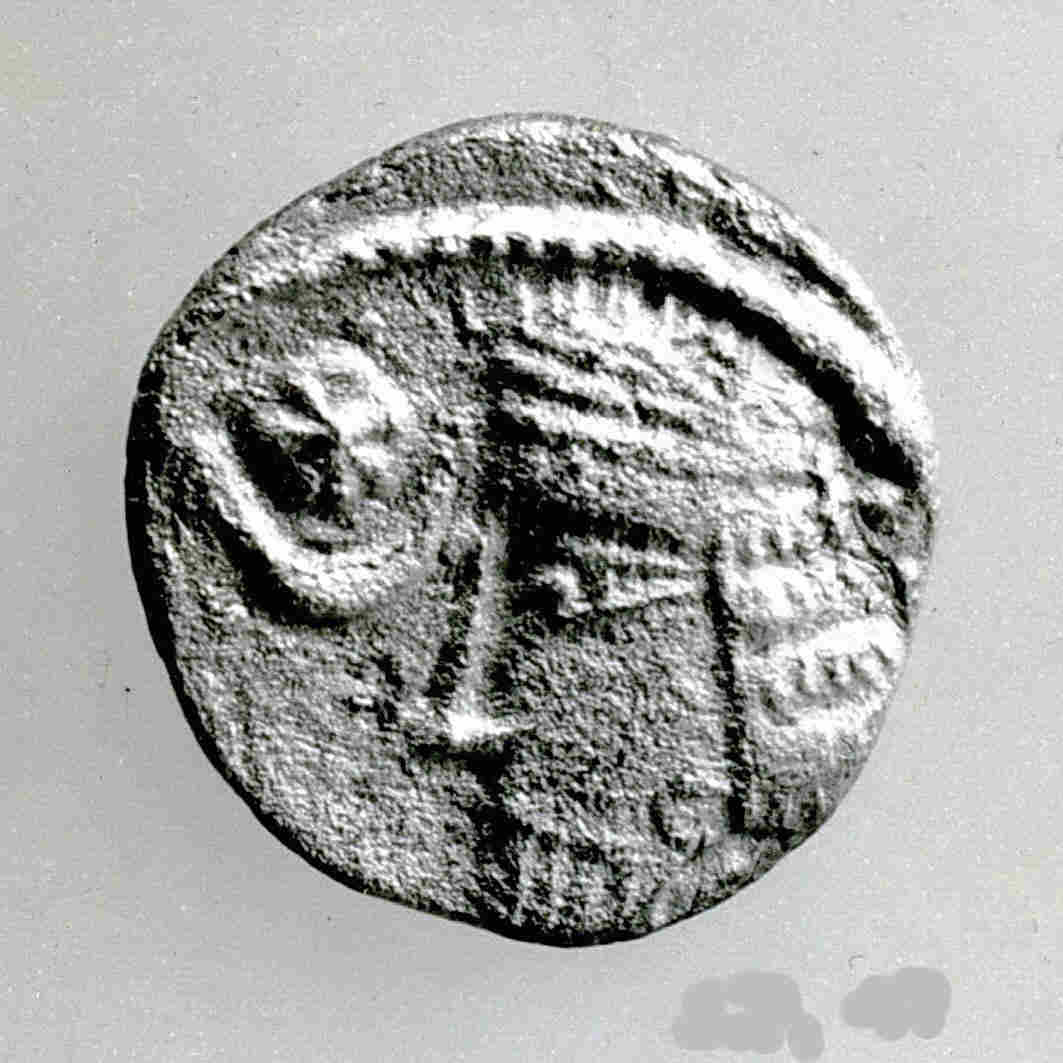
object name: coin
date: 201-300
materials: silver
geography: iran